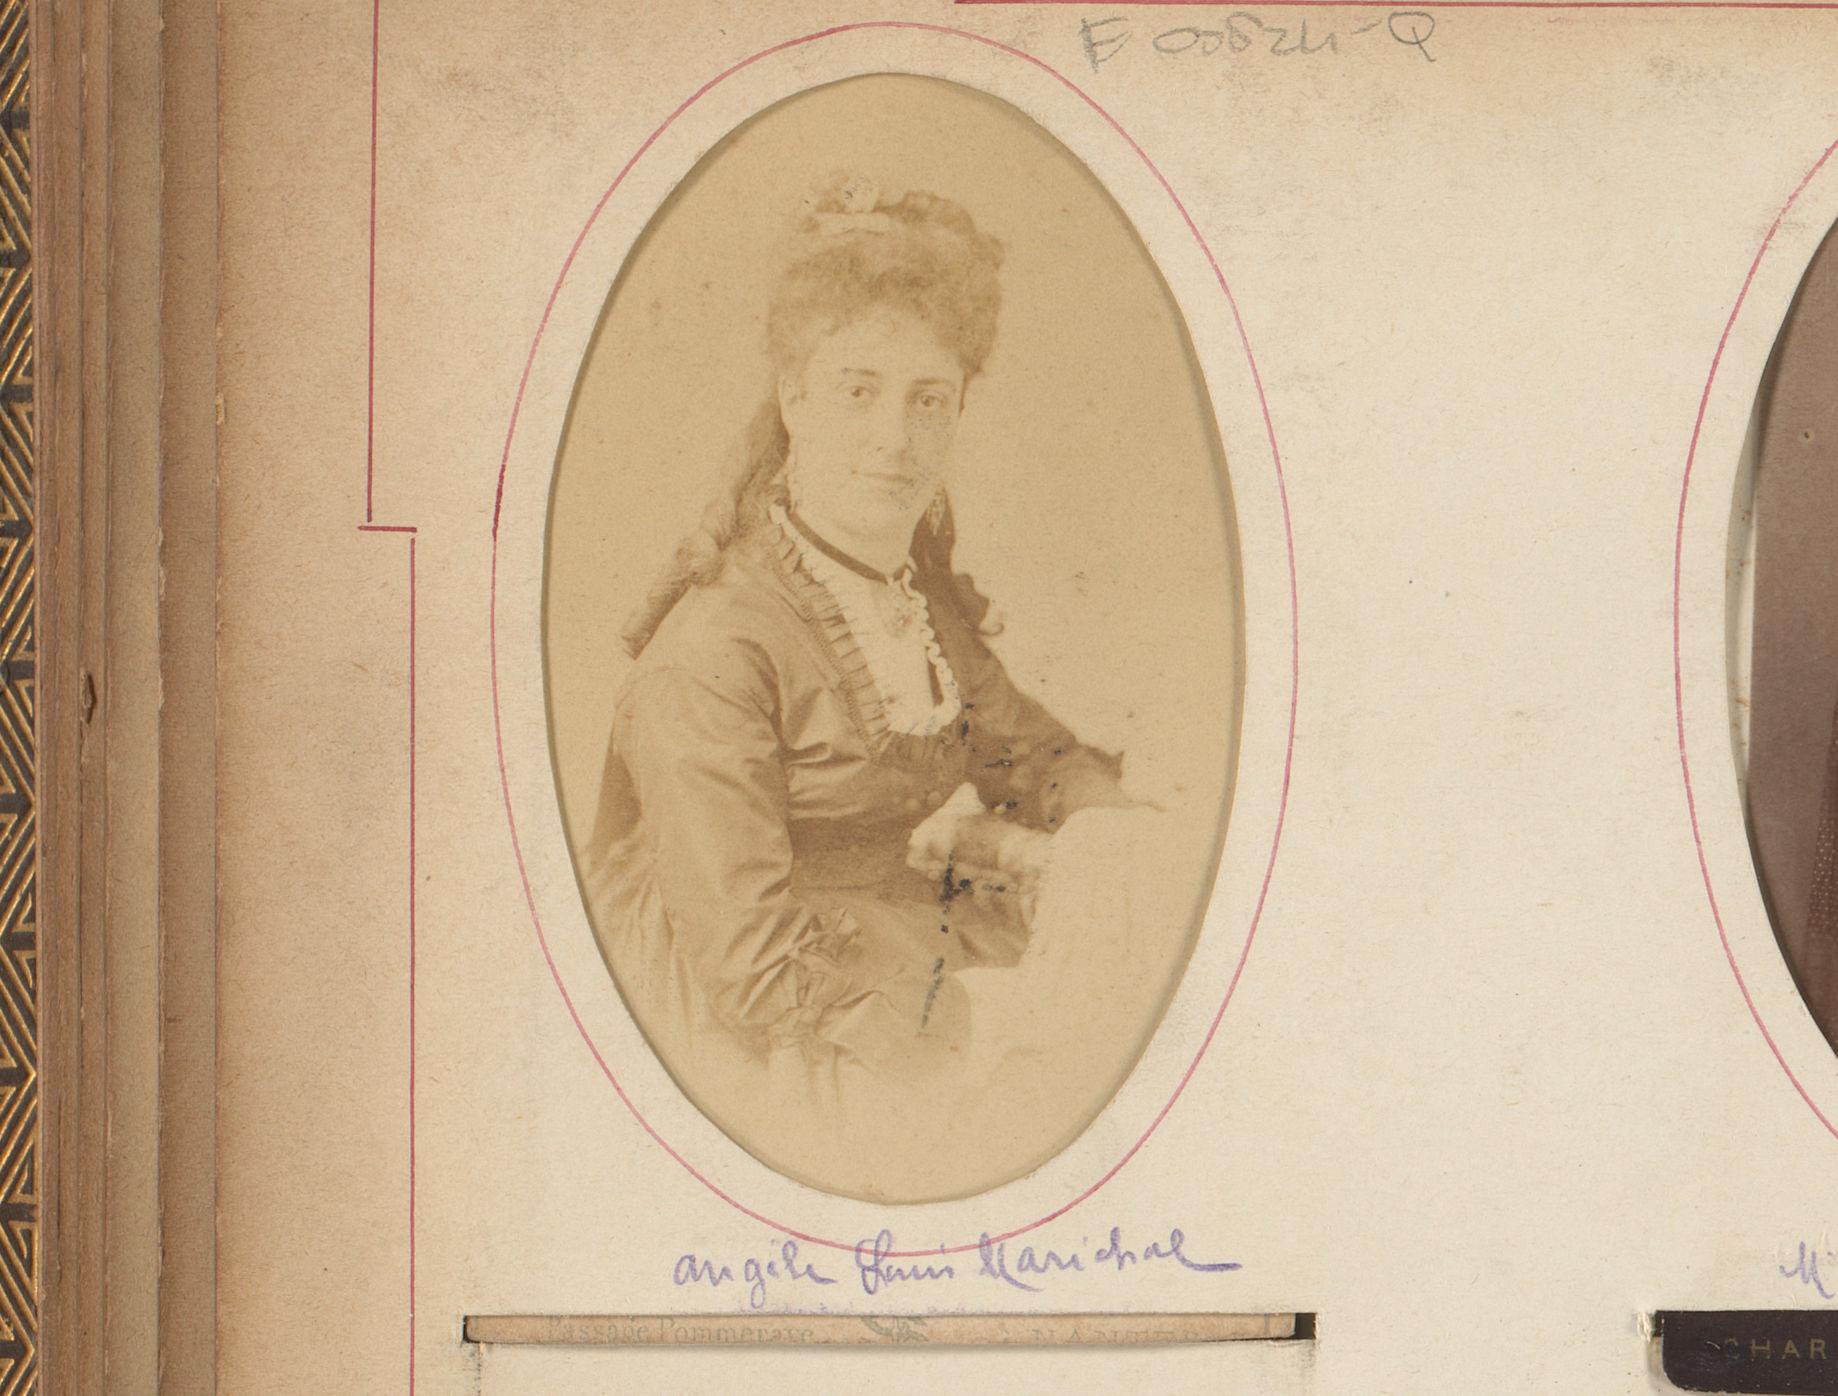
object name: carte de visite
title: Portret van Angéle Louis Maréchal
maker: jules alfred andré sébire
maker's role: fotograaf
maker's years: 1835-1895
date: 1861-1862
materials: cardboard, paper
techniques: albumen print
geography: nantes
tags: adult woman, historical persons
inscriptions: inscription: ‘EXPOSITION DE NANTES 1861’, address: ‘Passage Pommeraye,/ NANTES.’